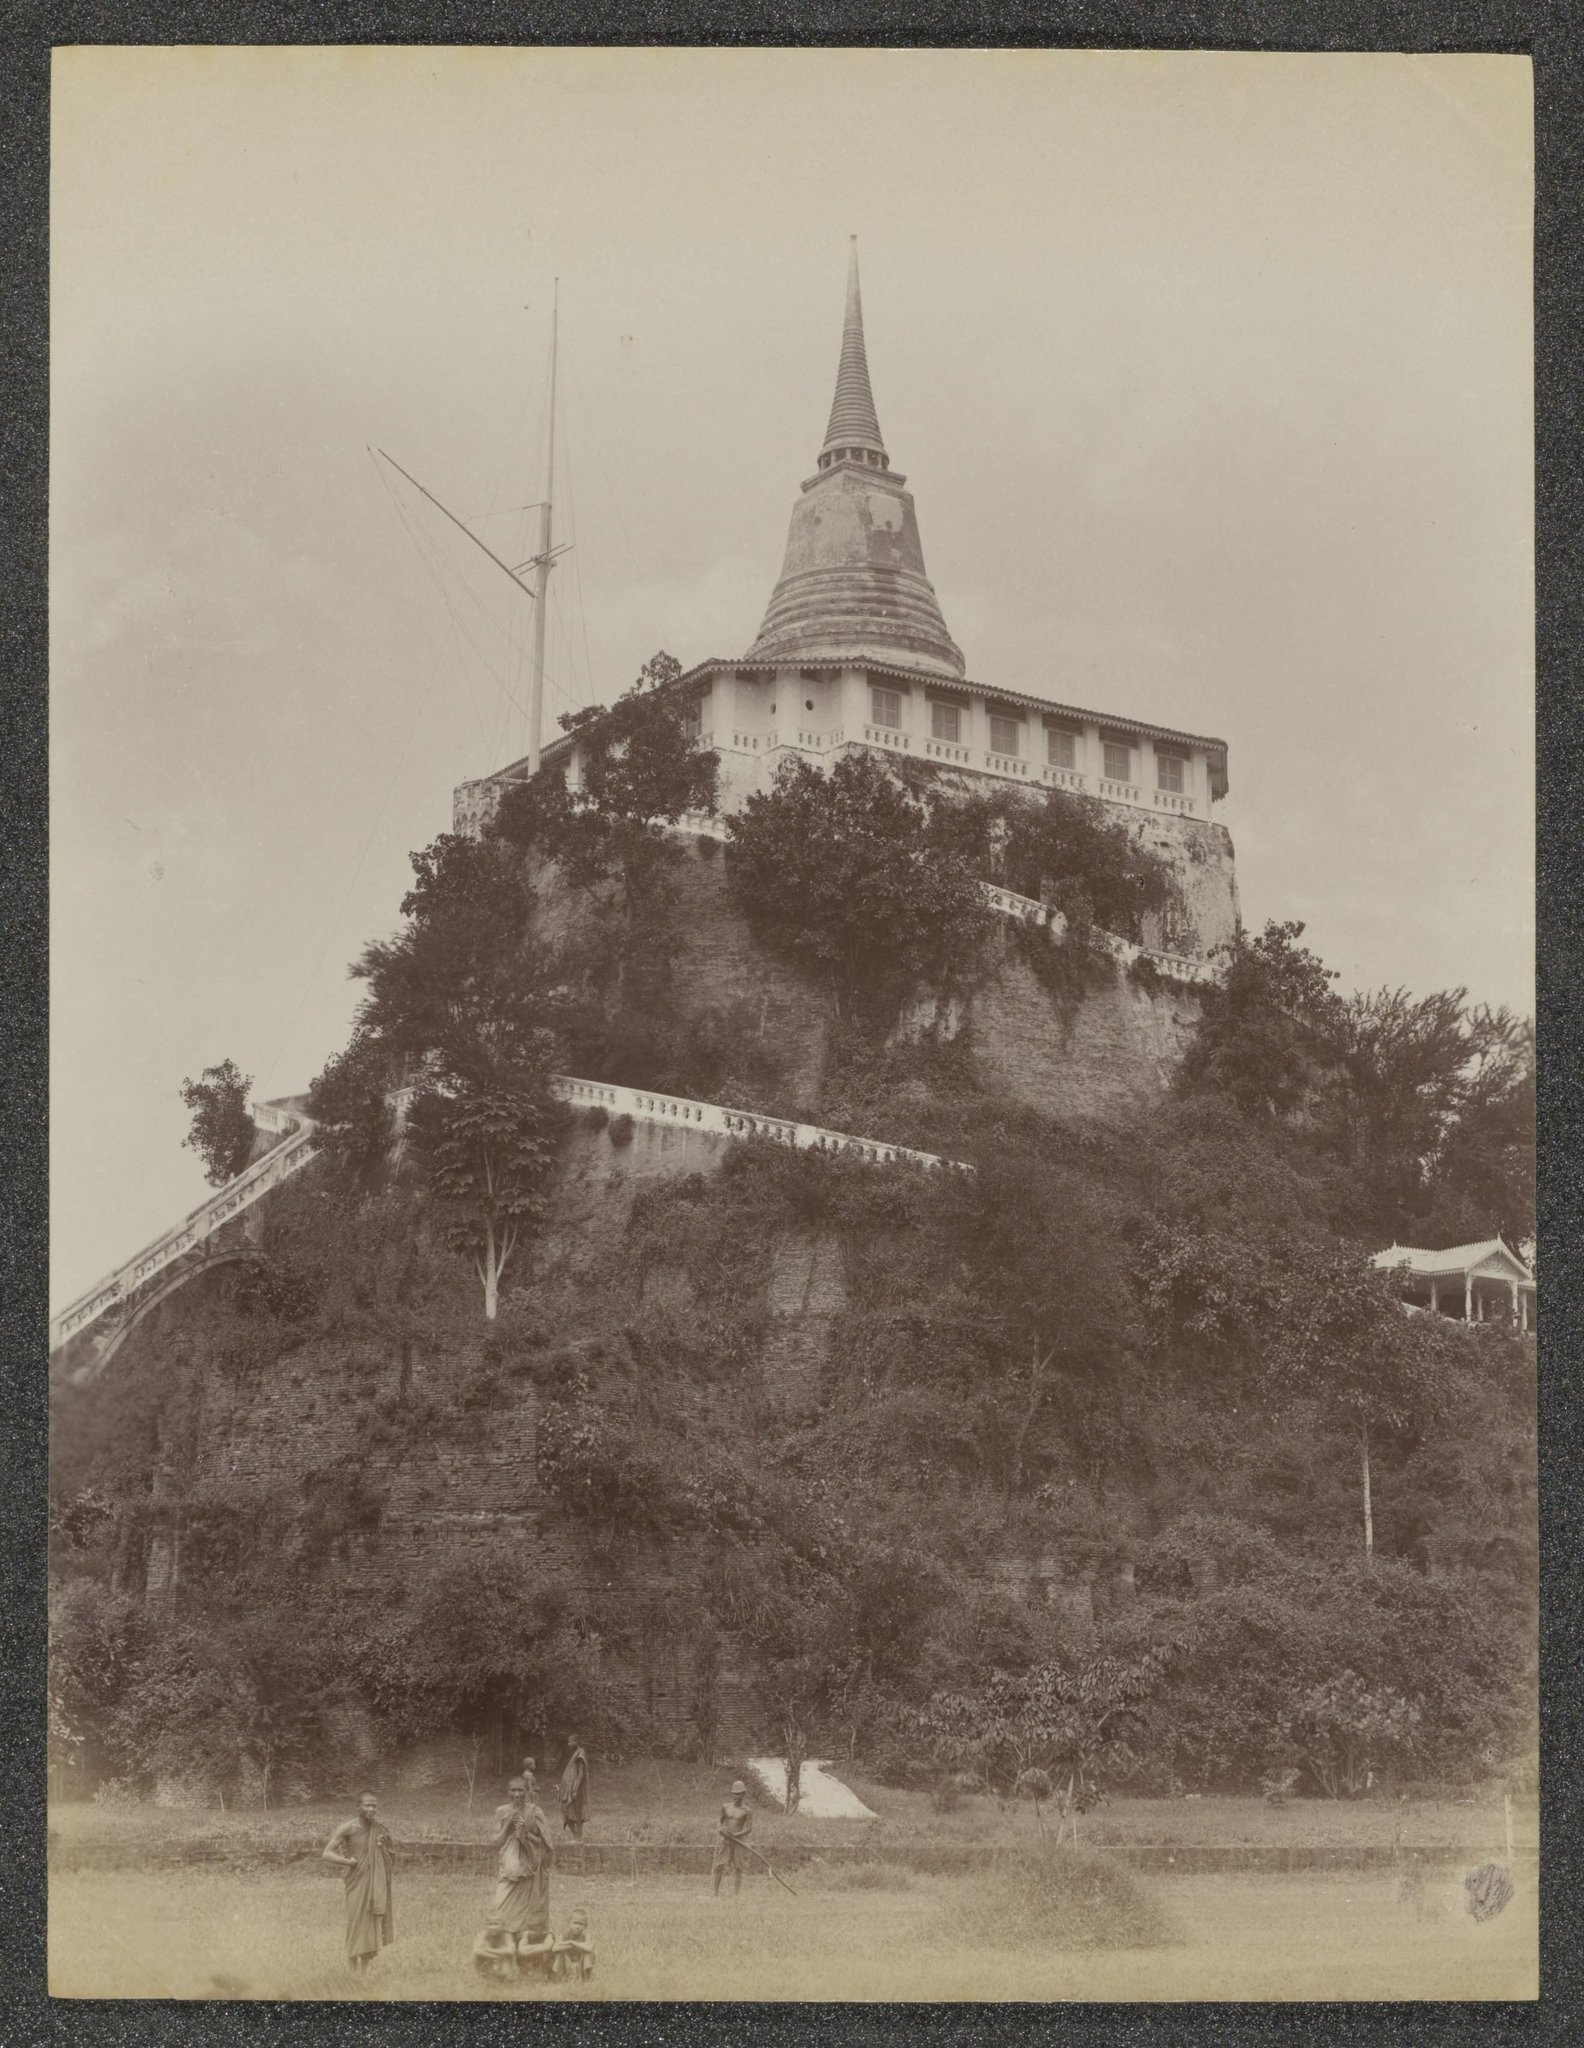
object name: album leaf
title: Monniken aan de voet van de toren van de Wat Saket-tempel in Bangkok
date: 1870-1900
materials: paper, photographic support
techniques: albumen print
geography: bangkok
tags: temple, shrine ~ hinduism, buddhism, jainism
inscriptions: check stamp: ‘G.R. Lambert Singapore’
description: Onderdeel van Album met 50 foto's van een reis door Zuidoost-Azië.